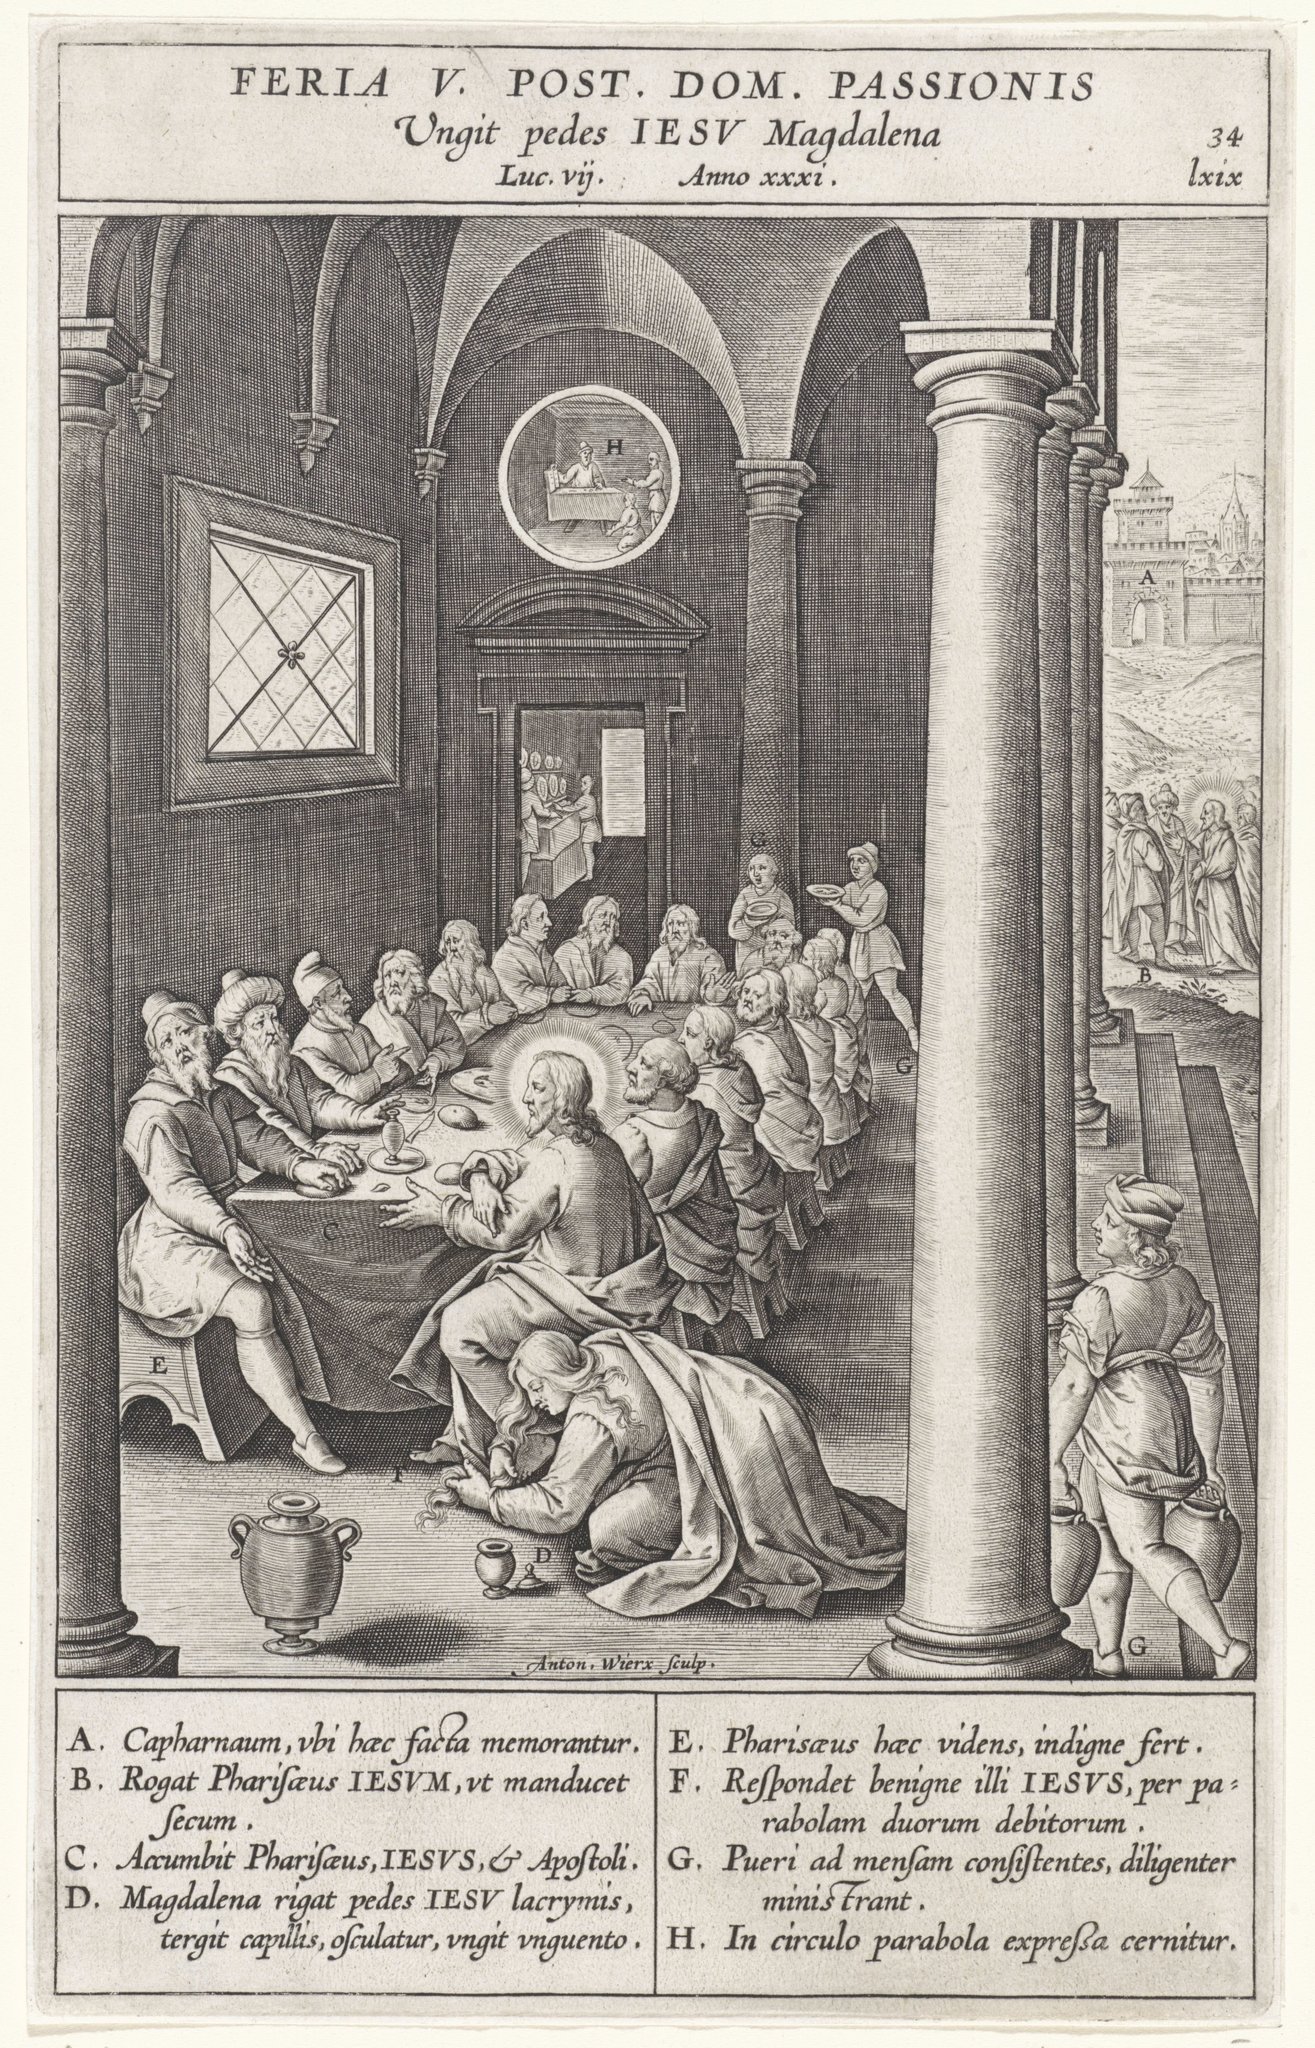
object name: print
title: Maria Magdalena zalft de voeten van Christus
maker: antonie wierix (ii)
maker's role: draughtsman, print maker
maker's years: 1555-1604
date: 1593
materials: paper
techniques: engraving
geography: antwerp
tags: christ's feet are anointed by mary (magdalene)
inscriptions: collector's mark: Lugt 2165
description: Christus is te gast bij Simon de Farizeeër en zit aan tafel. Maria Magdalena zit geknield naast Christus en droogt zijn voeten af met haar haren. Bij verschillende elementen uit de voorstelling staan letters die corresponderen met de legenda in de marge.